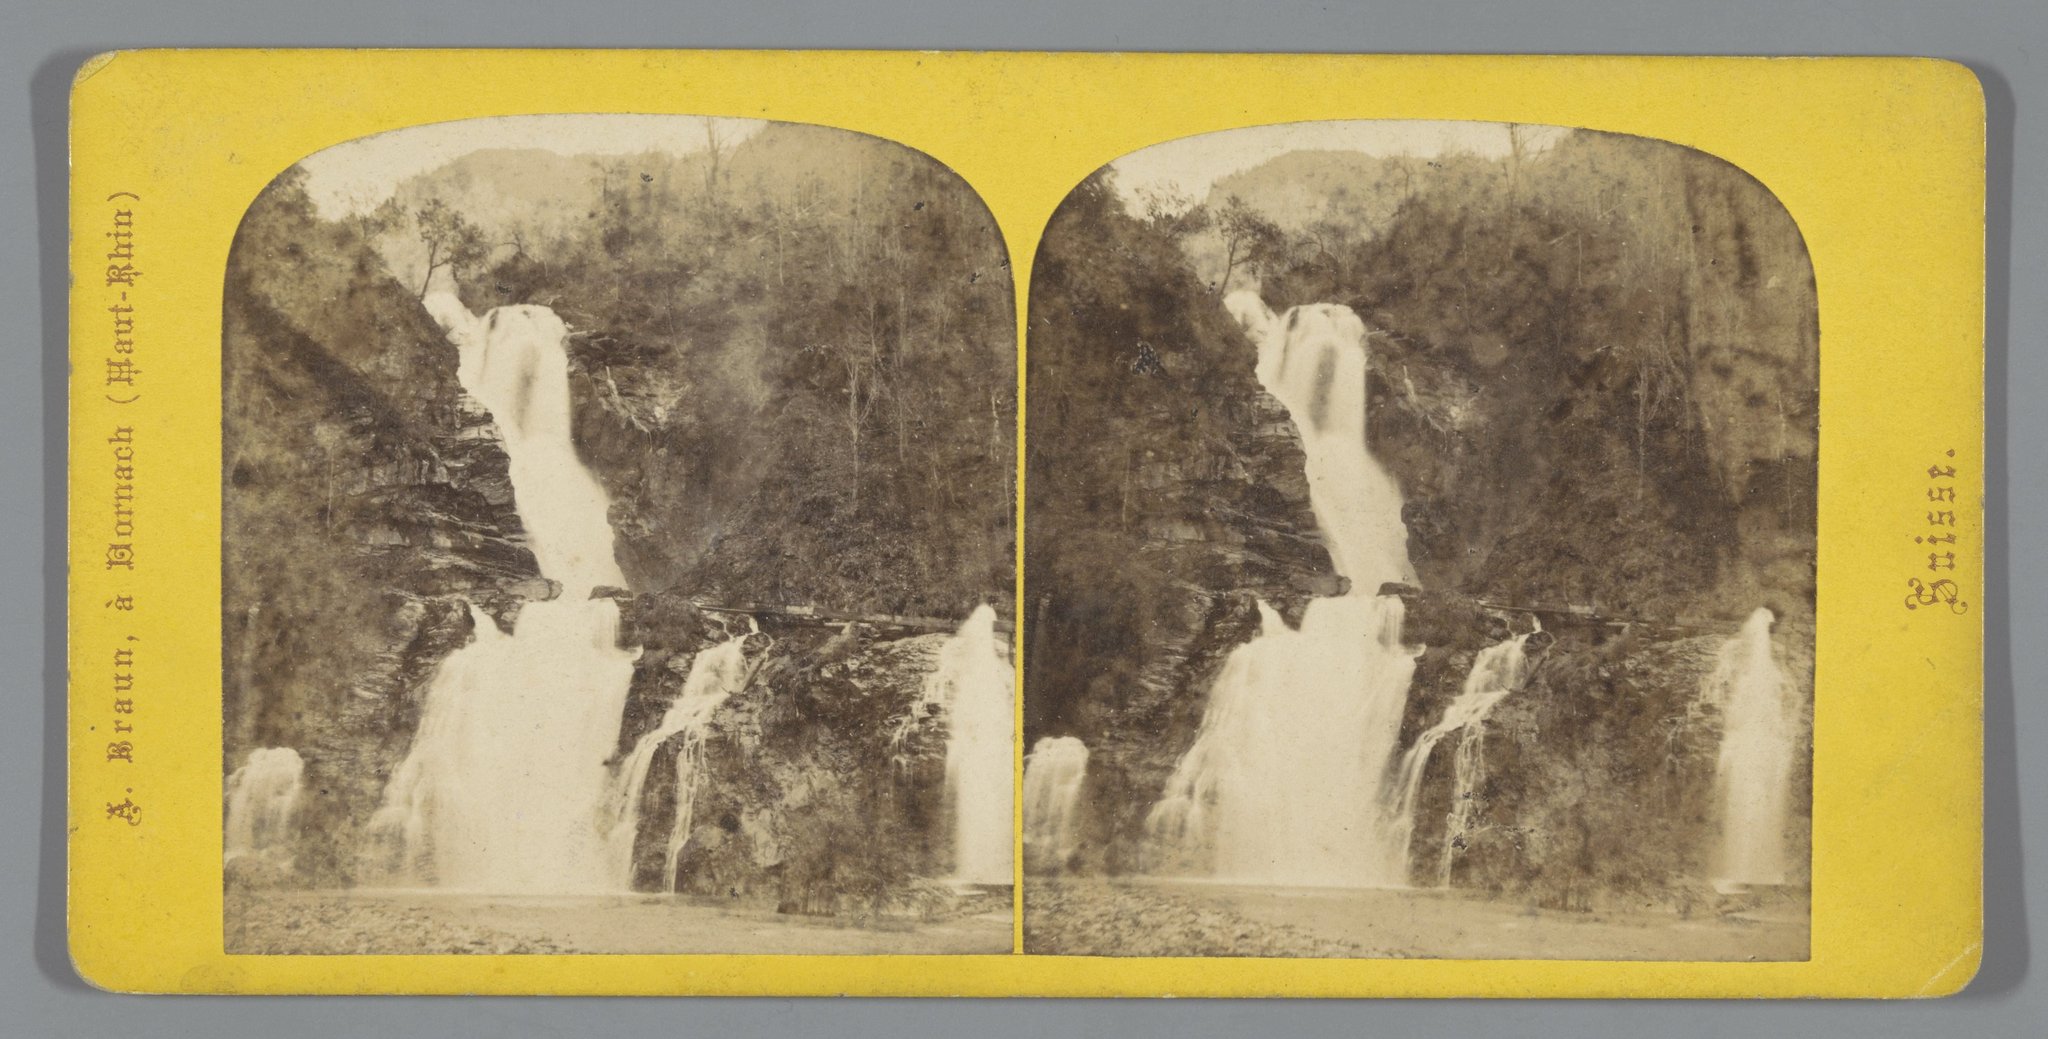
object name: stereograph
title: Chûtes du Reichenbach à Meyringen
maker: Anonymous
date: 1879-1889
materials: cardboard, paper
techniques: albumen print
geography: meiringen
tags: waterfall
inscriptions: number: ‘No 3723.’